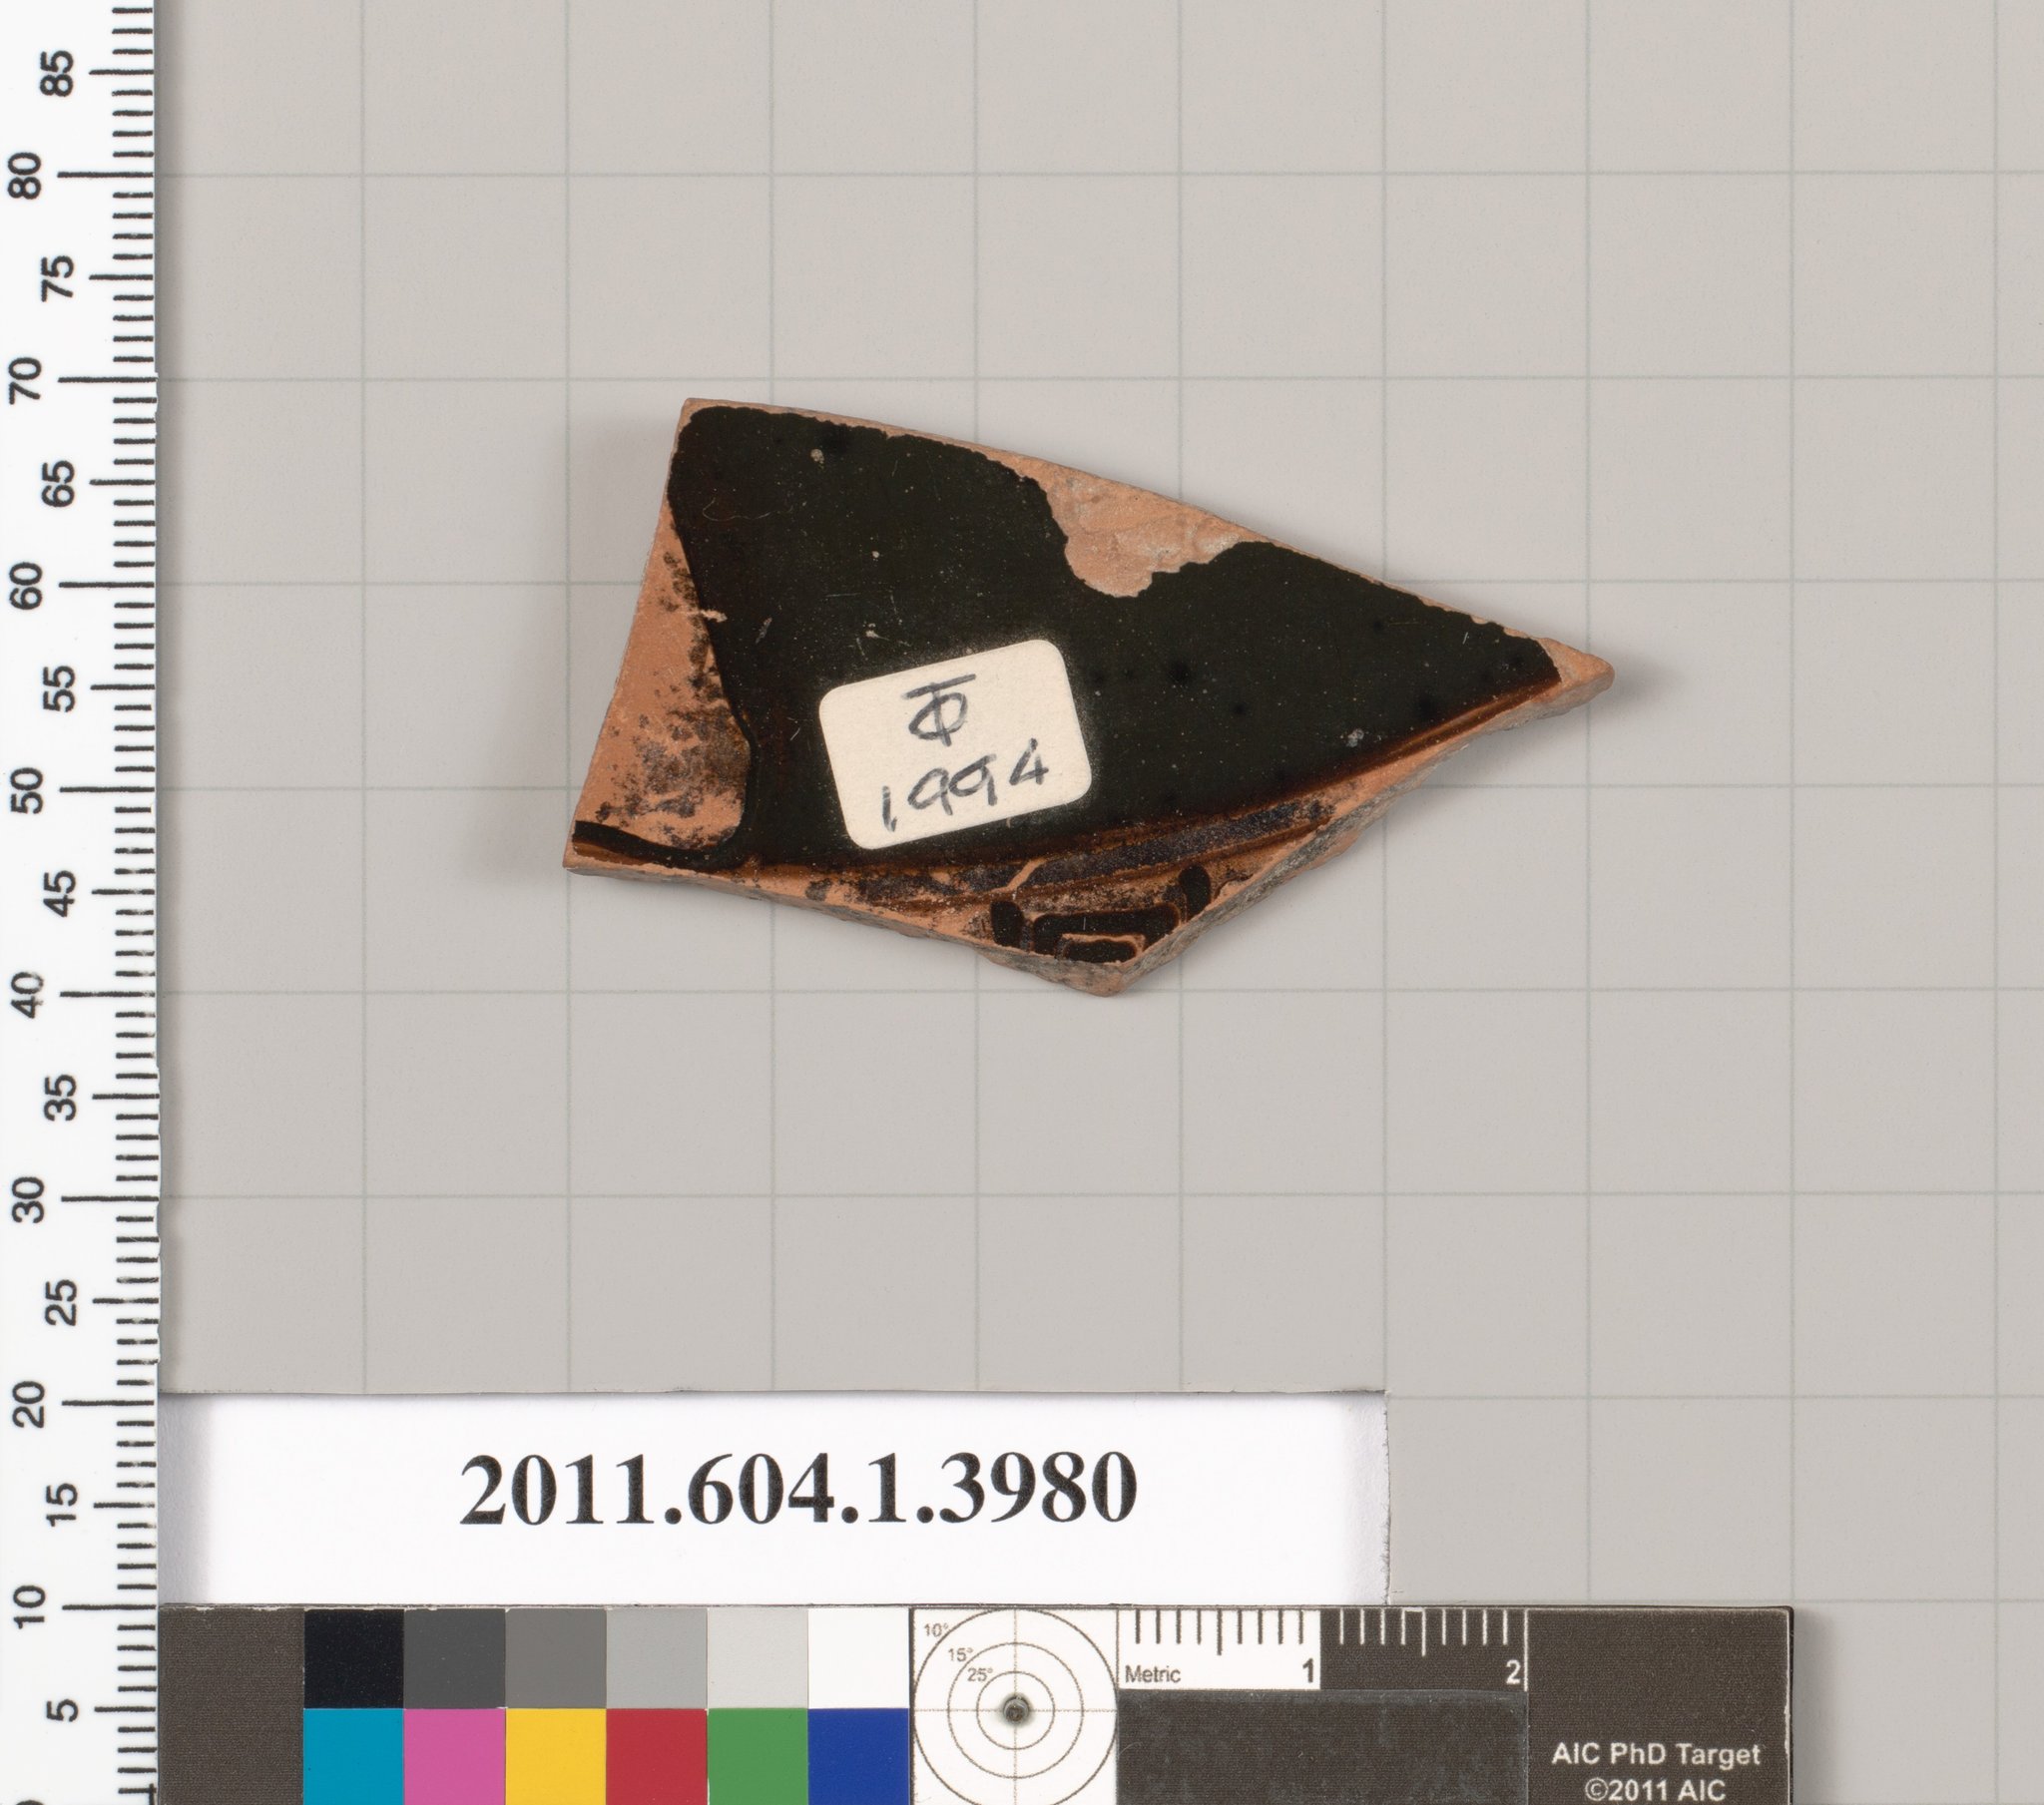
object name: kylix fragment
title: Terracotta fragment of a kylix (drinking cup)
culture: greek, attic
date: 510-490 BCE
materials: terracotta